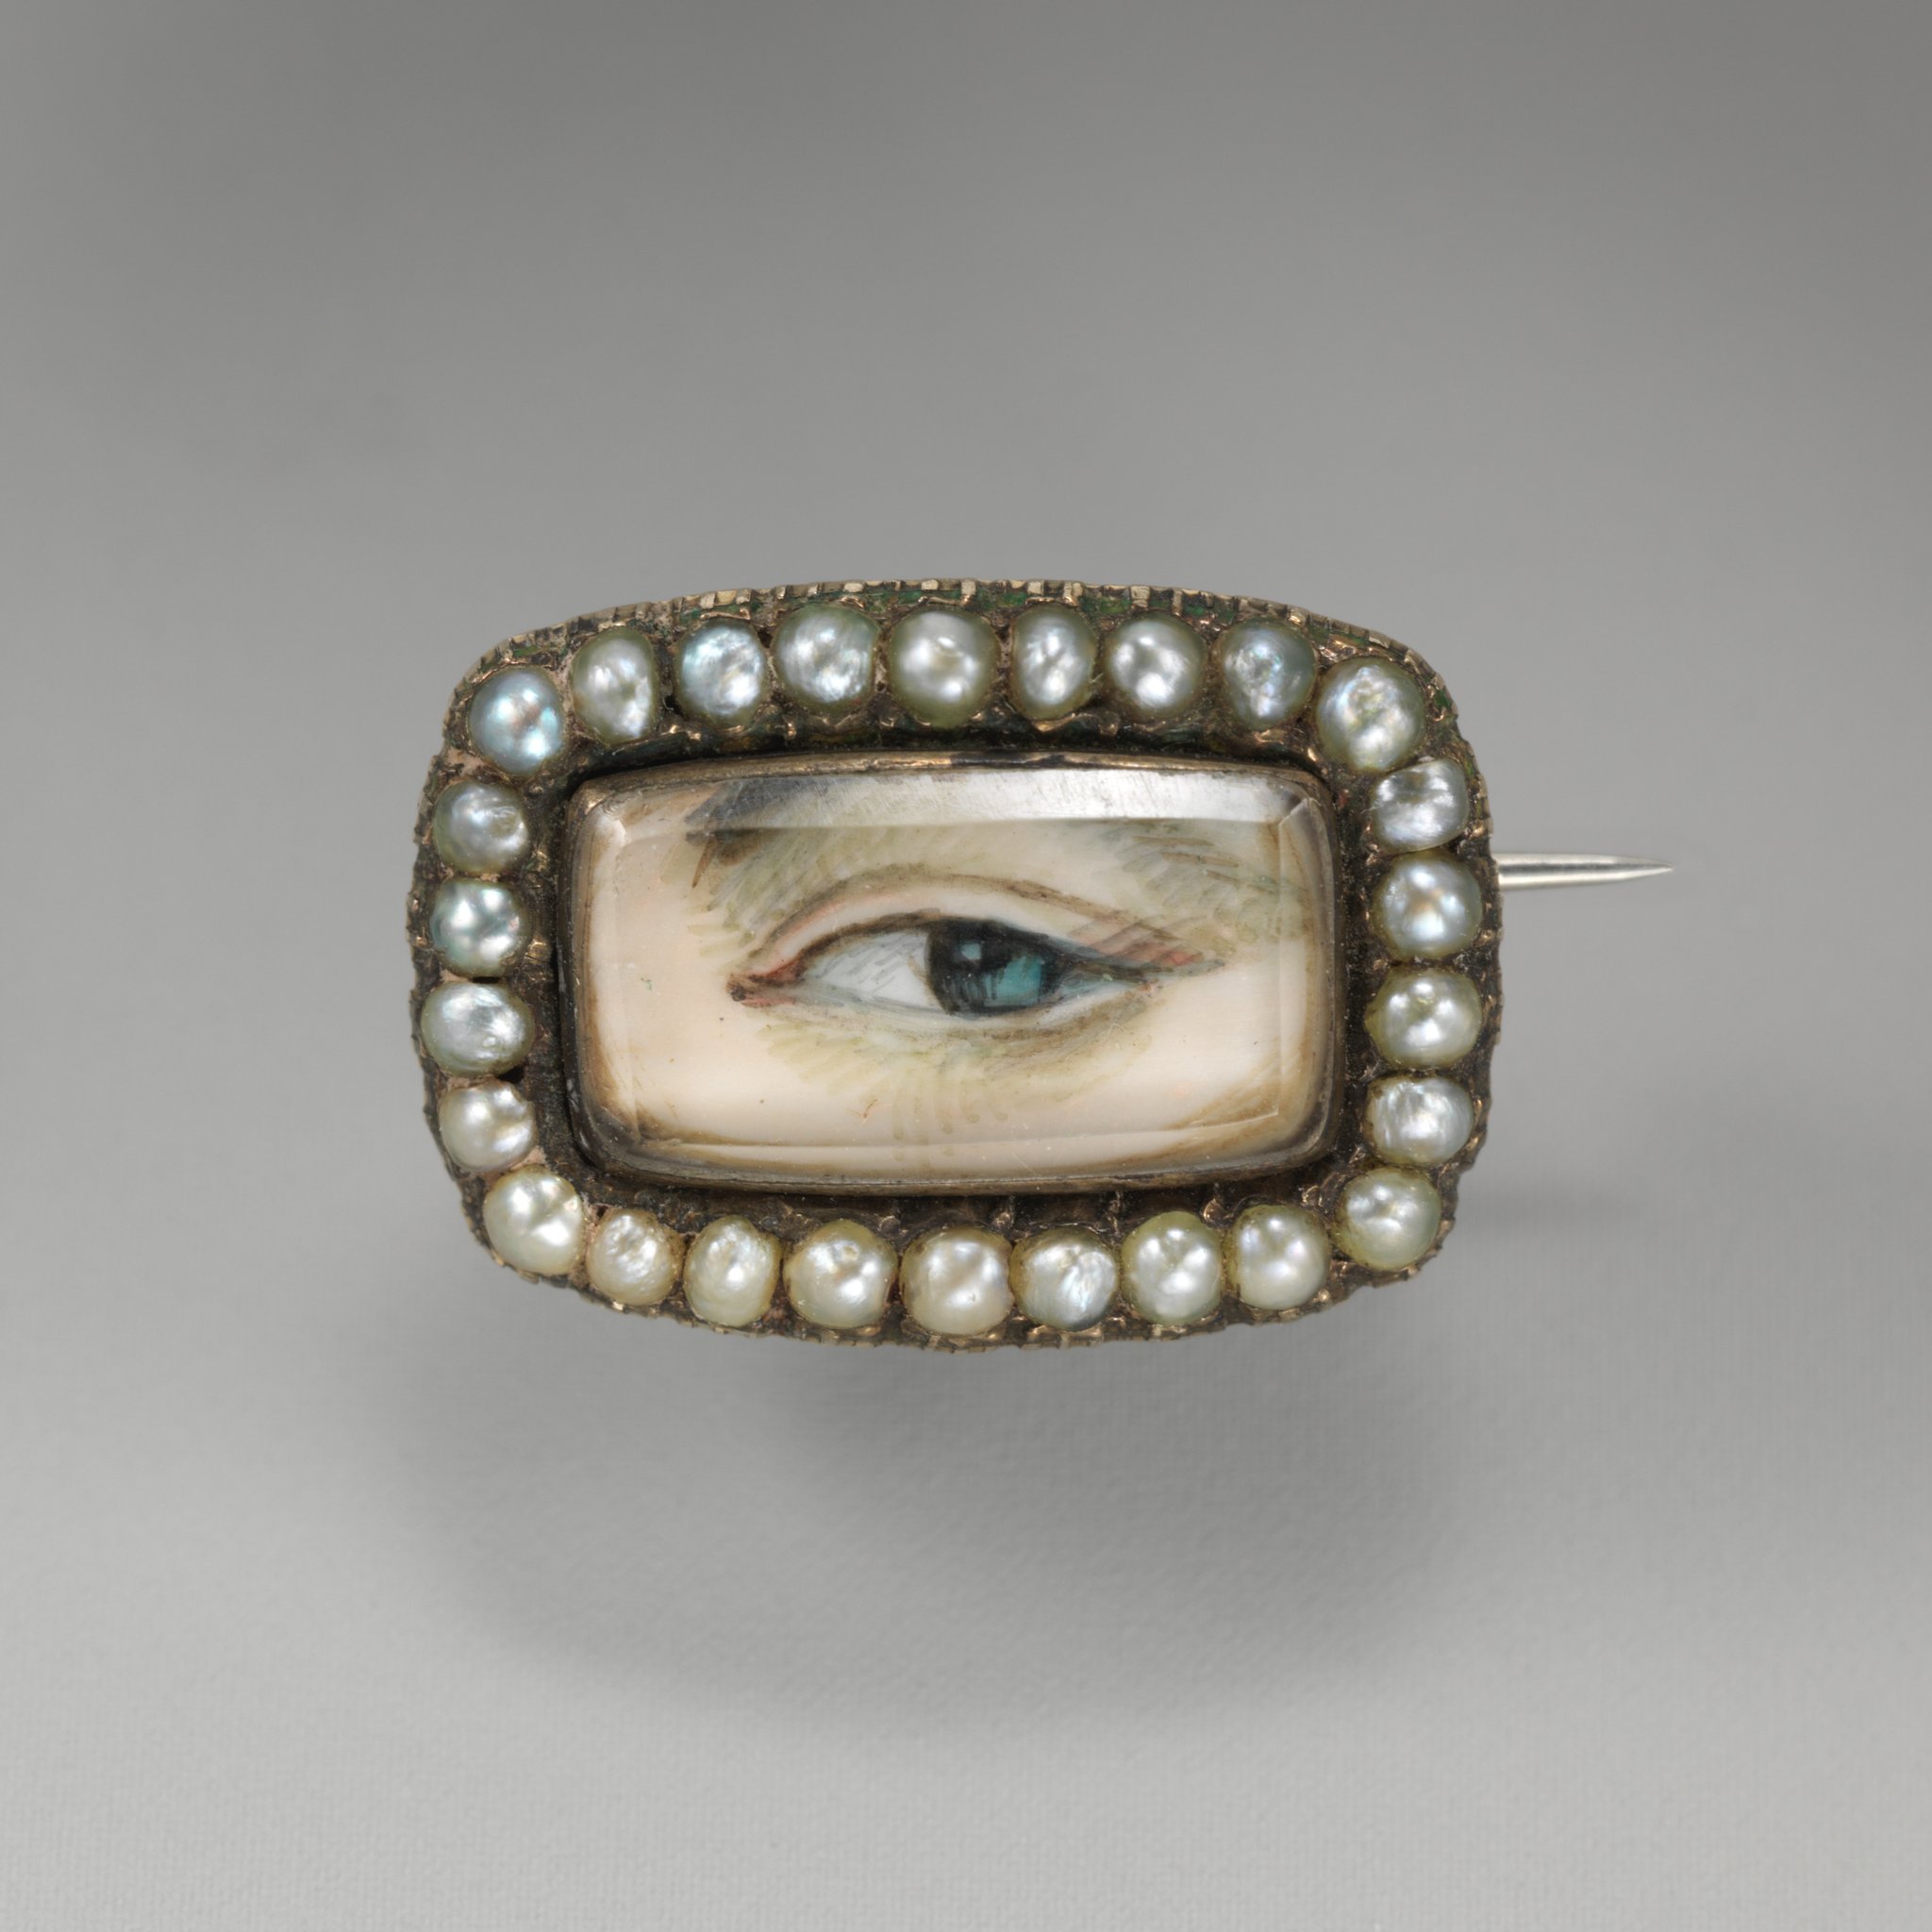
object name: brooch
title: "Eye" brooch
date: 1801-1833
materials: gold, ivory, pearl, quartz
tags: eyes